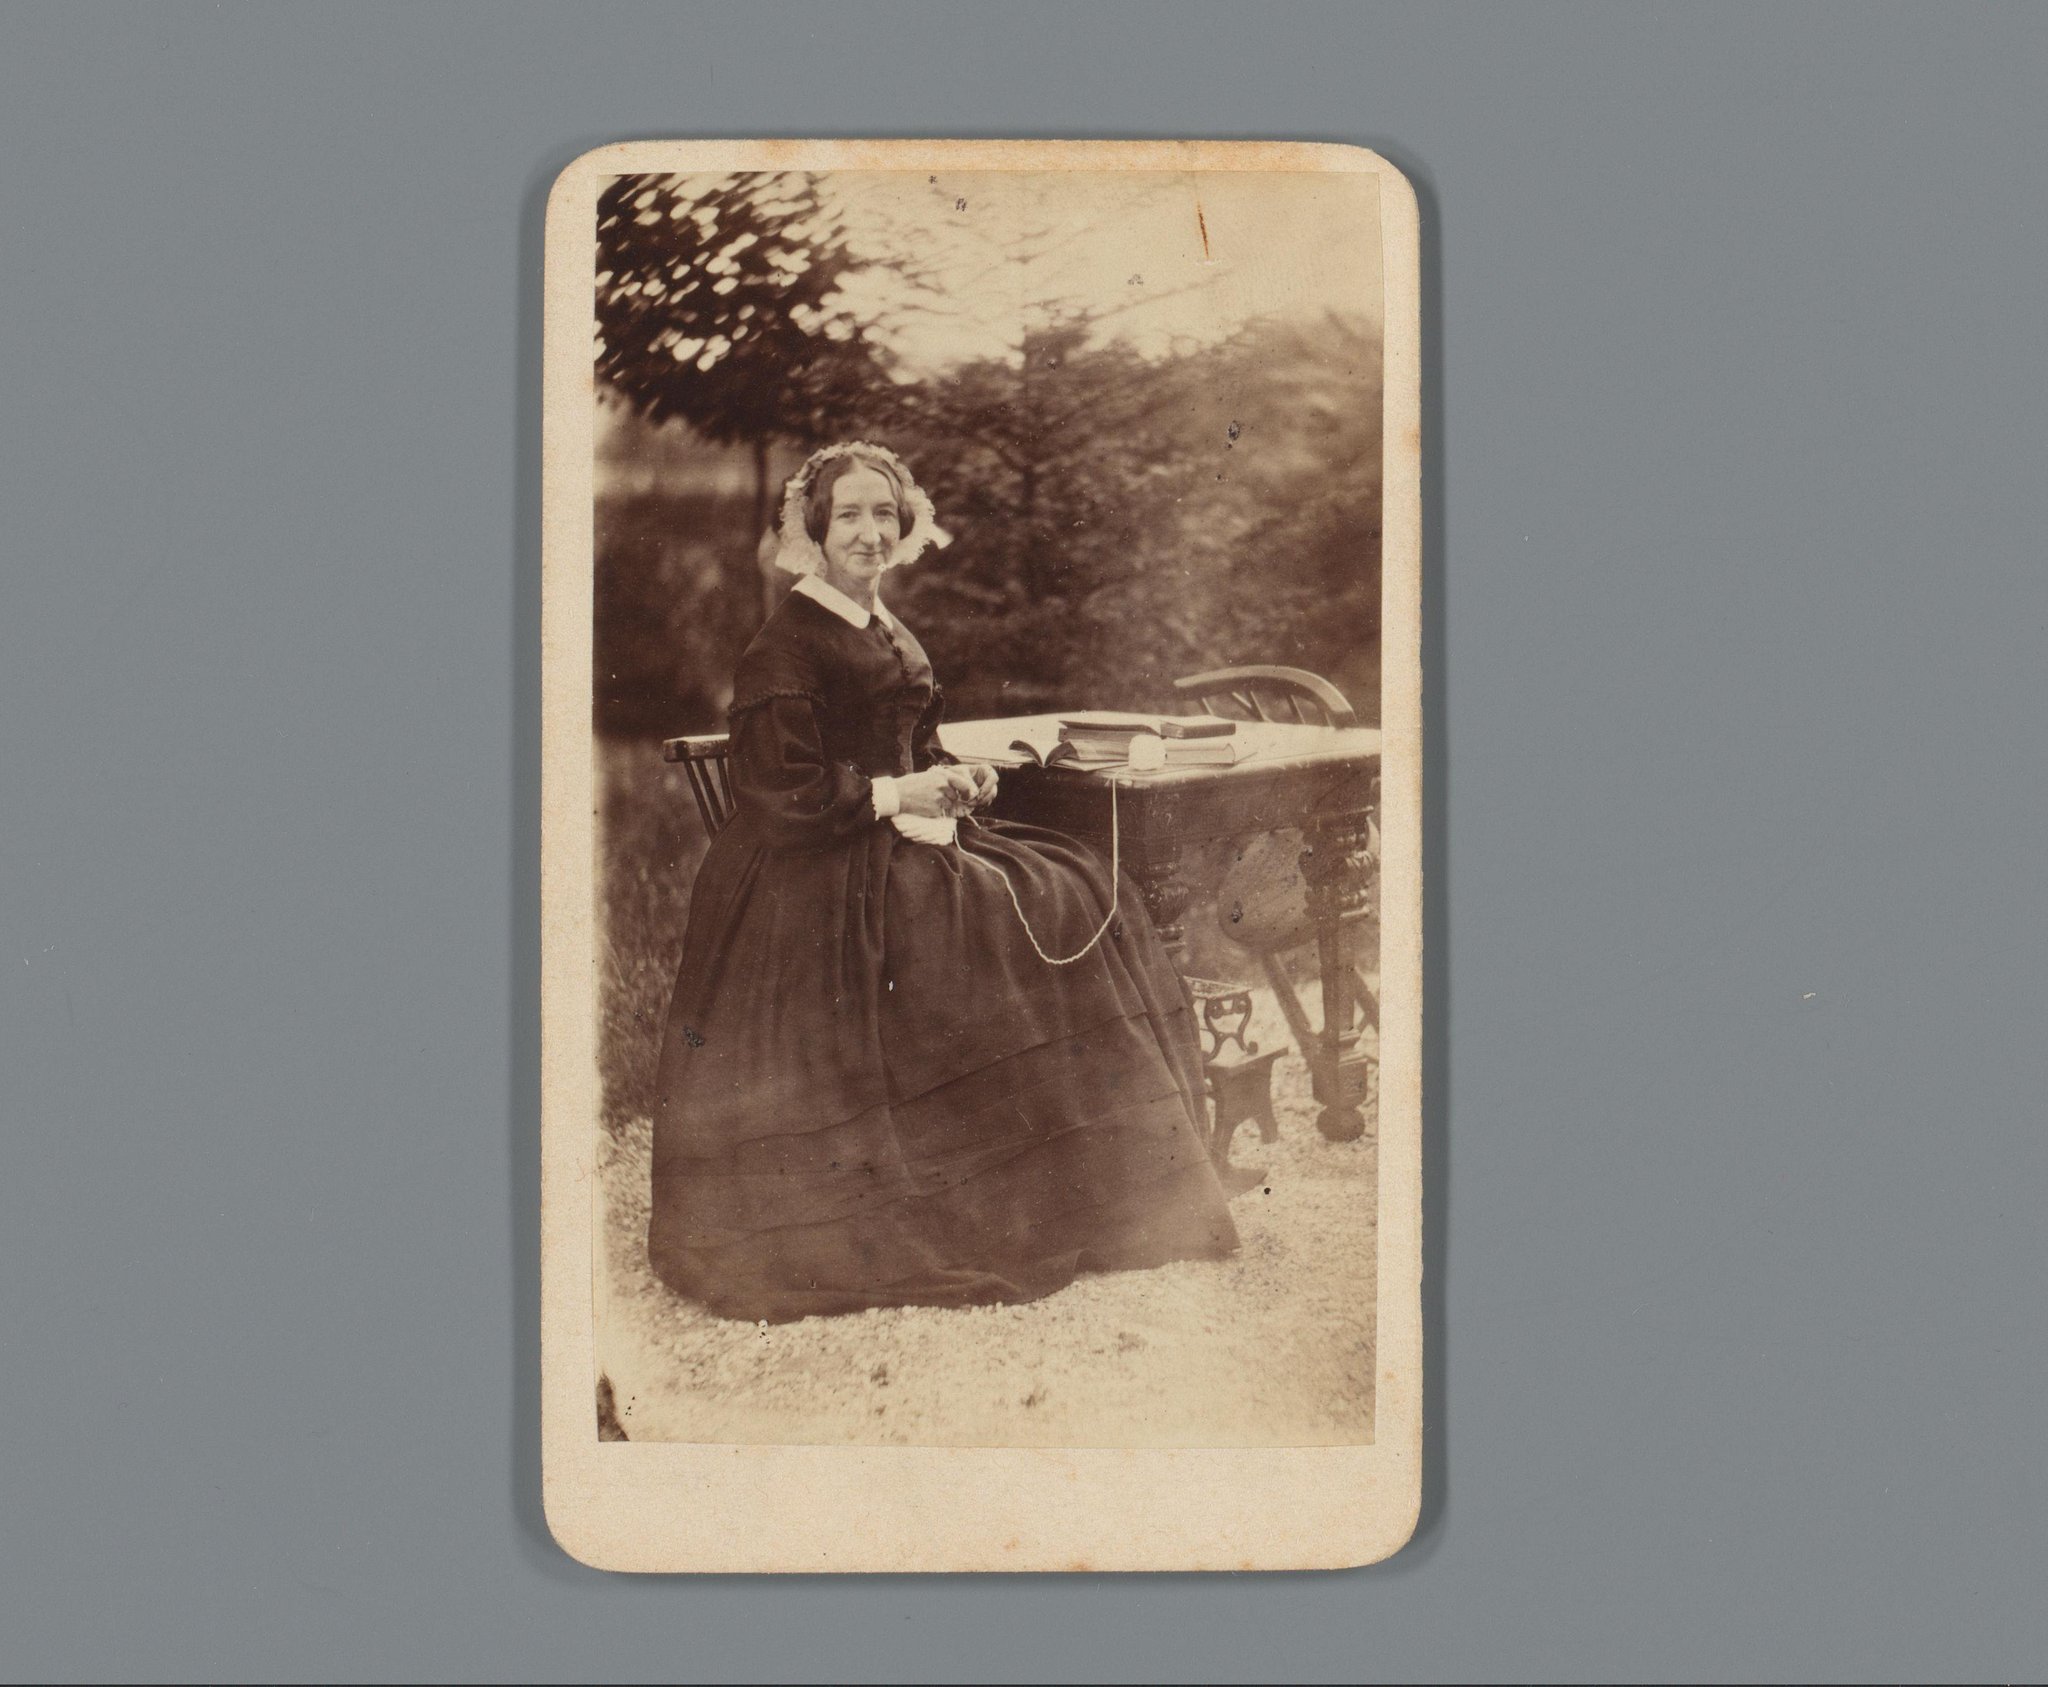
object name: carte de visite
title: Portret van Maria Sara Albertina Swellengrebel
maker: Anonymous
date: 1850-1867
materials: cardboard, photographic support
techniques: albumen print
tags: maria sara albertina swellengrebel, historical persons - bb - woman, (other forms of) needlework, e.g.: crocheting, knitting, embroidering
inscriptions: inscription: ‘Maria Sara Albertine Swellengrebel / dr. van Wm Sw en CW van Mierop’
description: Portret van Maria Sara Albertina Swellengrebel. Zittend buiten, ten voeten uit, aan een tafel bezig met een handwerkje.